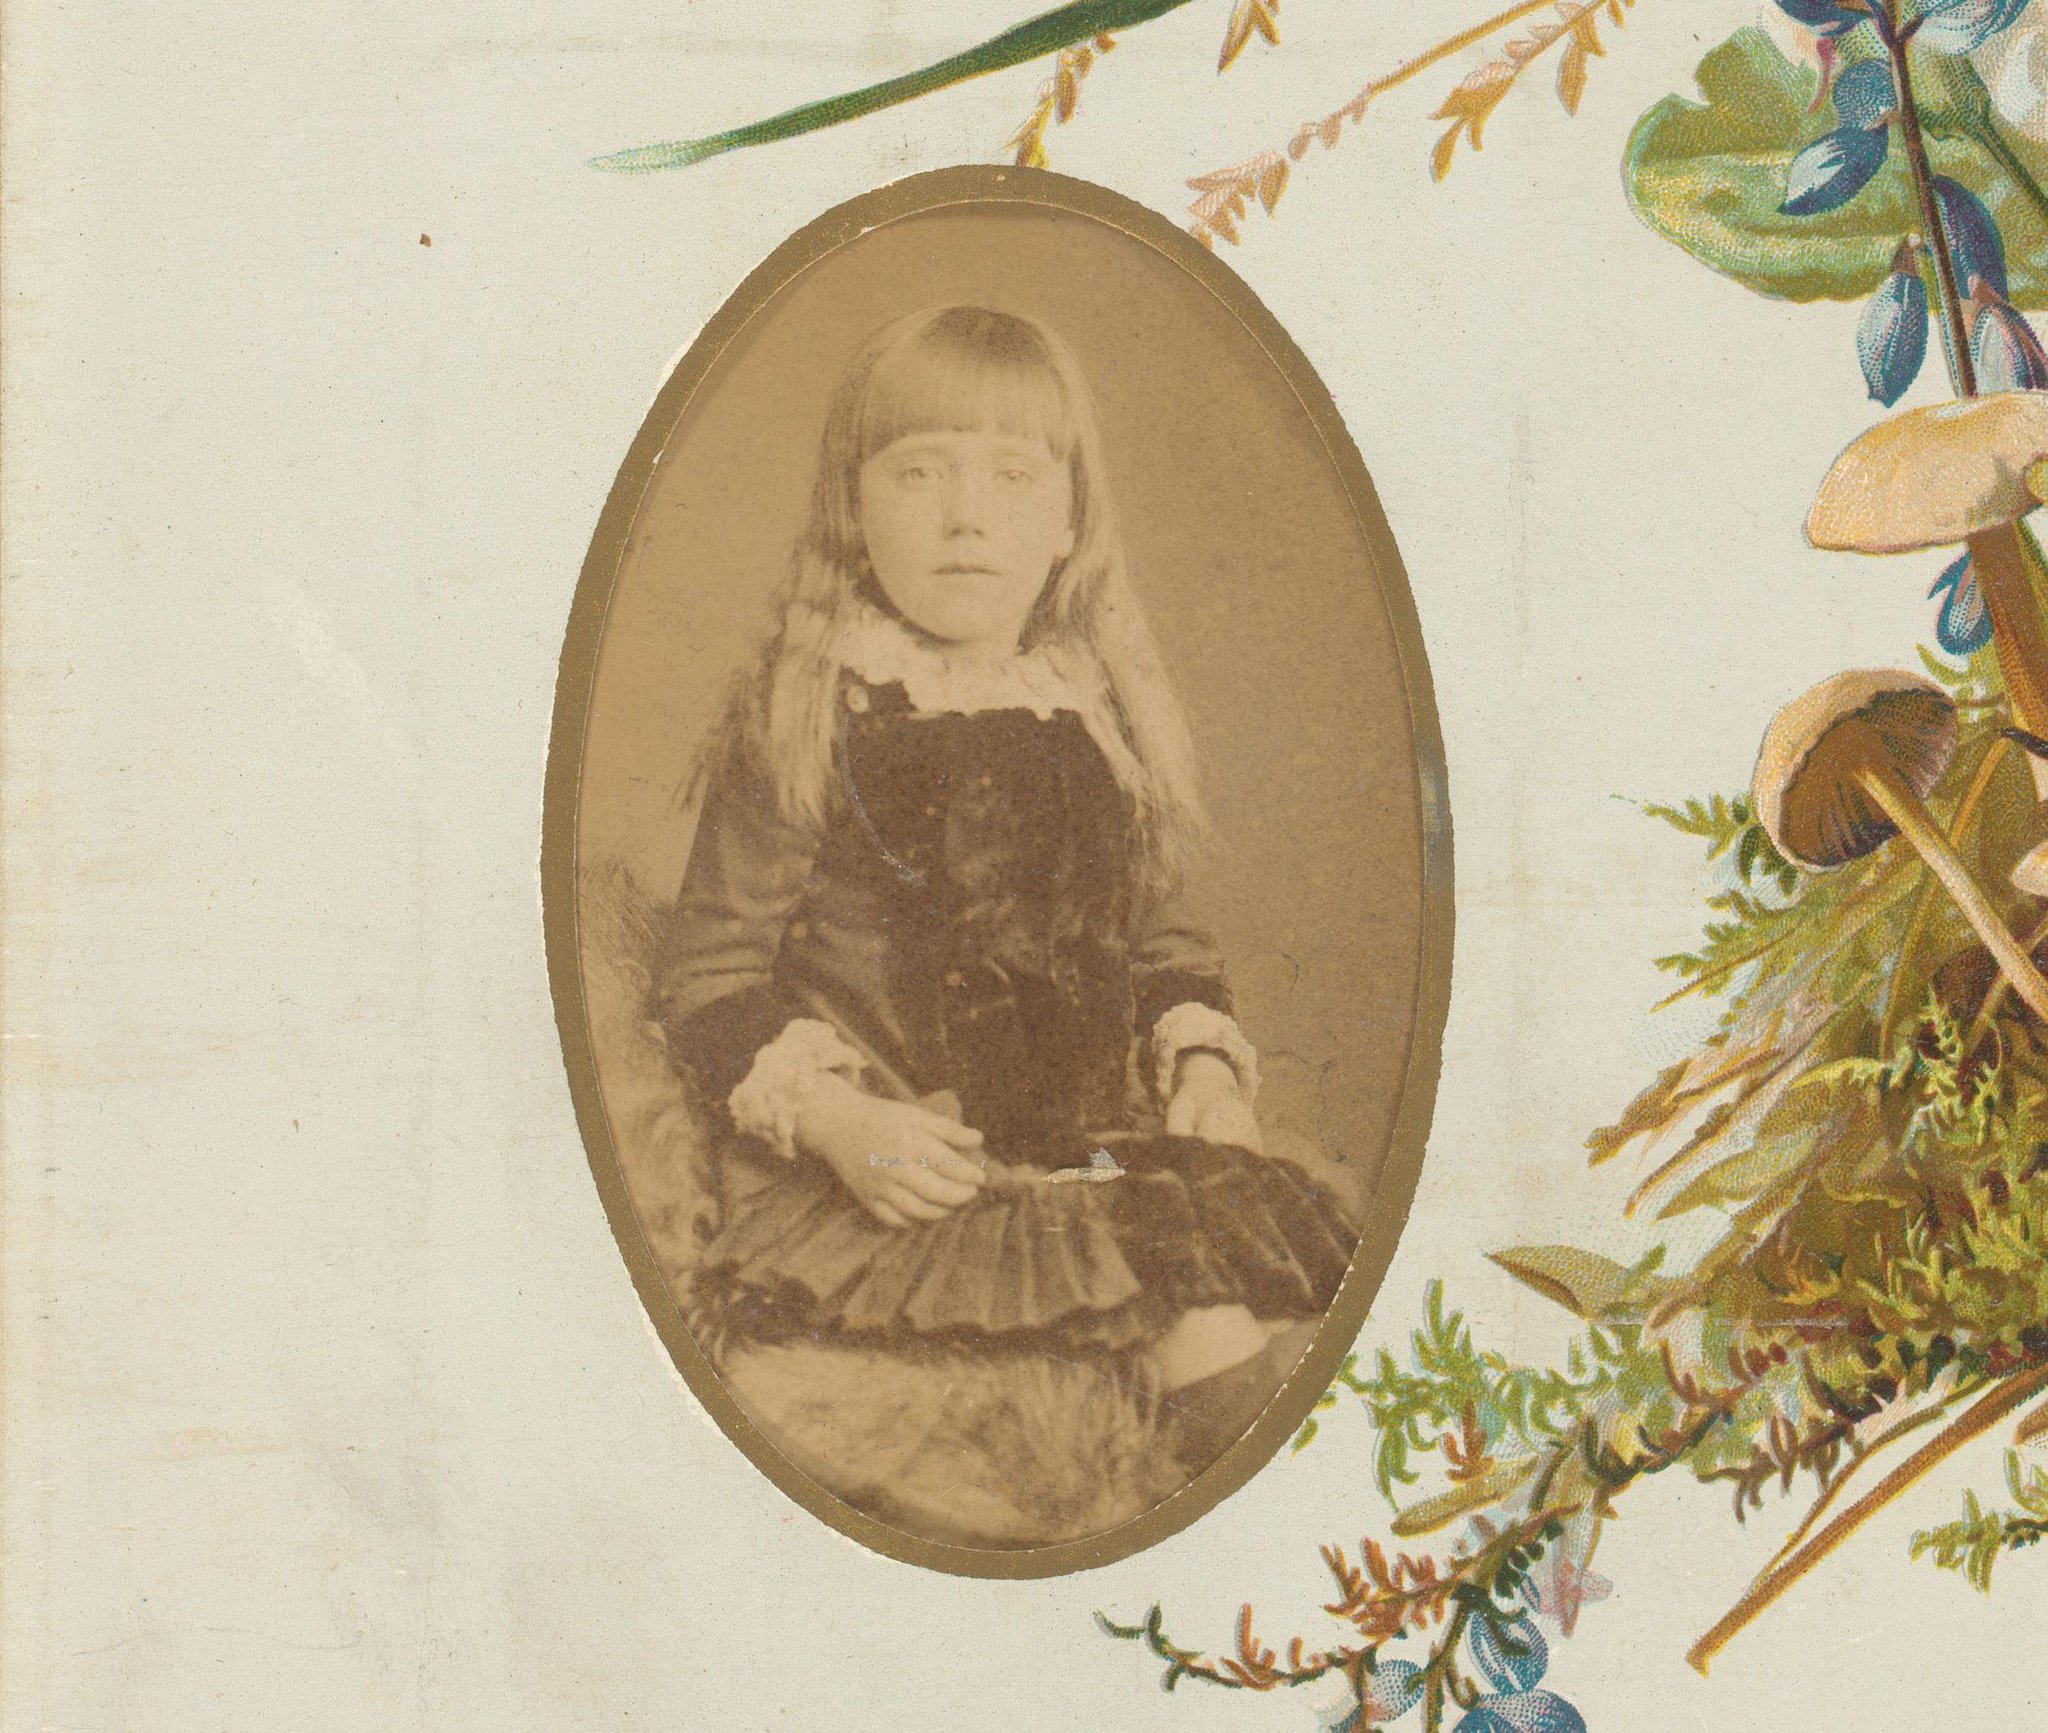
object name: photograph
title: Portret van een zittend meisje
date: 1860-1880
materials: cardboard, photographic support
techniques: albumen print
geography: london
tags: sitting figure - aa - female human figure, historical persons - bb - woman, girl (child between toddler and youth)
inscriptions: inscription: ‘PHOTOGRAPHERS to HIS HIGHNESS/ AKBALODDOWLA./ EX KING [...] OF OUDE/ Hellis & Sons/ Portrait & Landscape Photographers/ 13 Silver Street, Notting Hill Gate W./ 30, Clapham Road S.W./ and/ 6, The Pavement Clapham Common S.W./ London/ Negatives kept./ Copies may be had./ This or any other portrait enlarged to life size/ and artistically painted in oil or water Colours.’